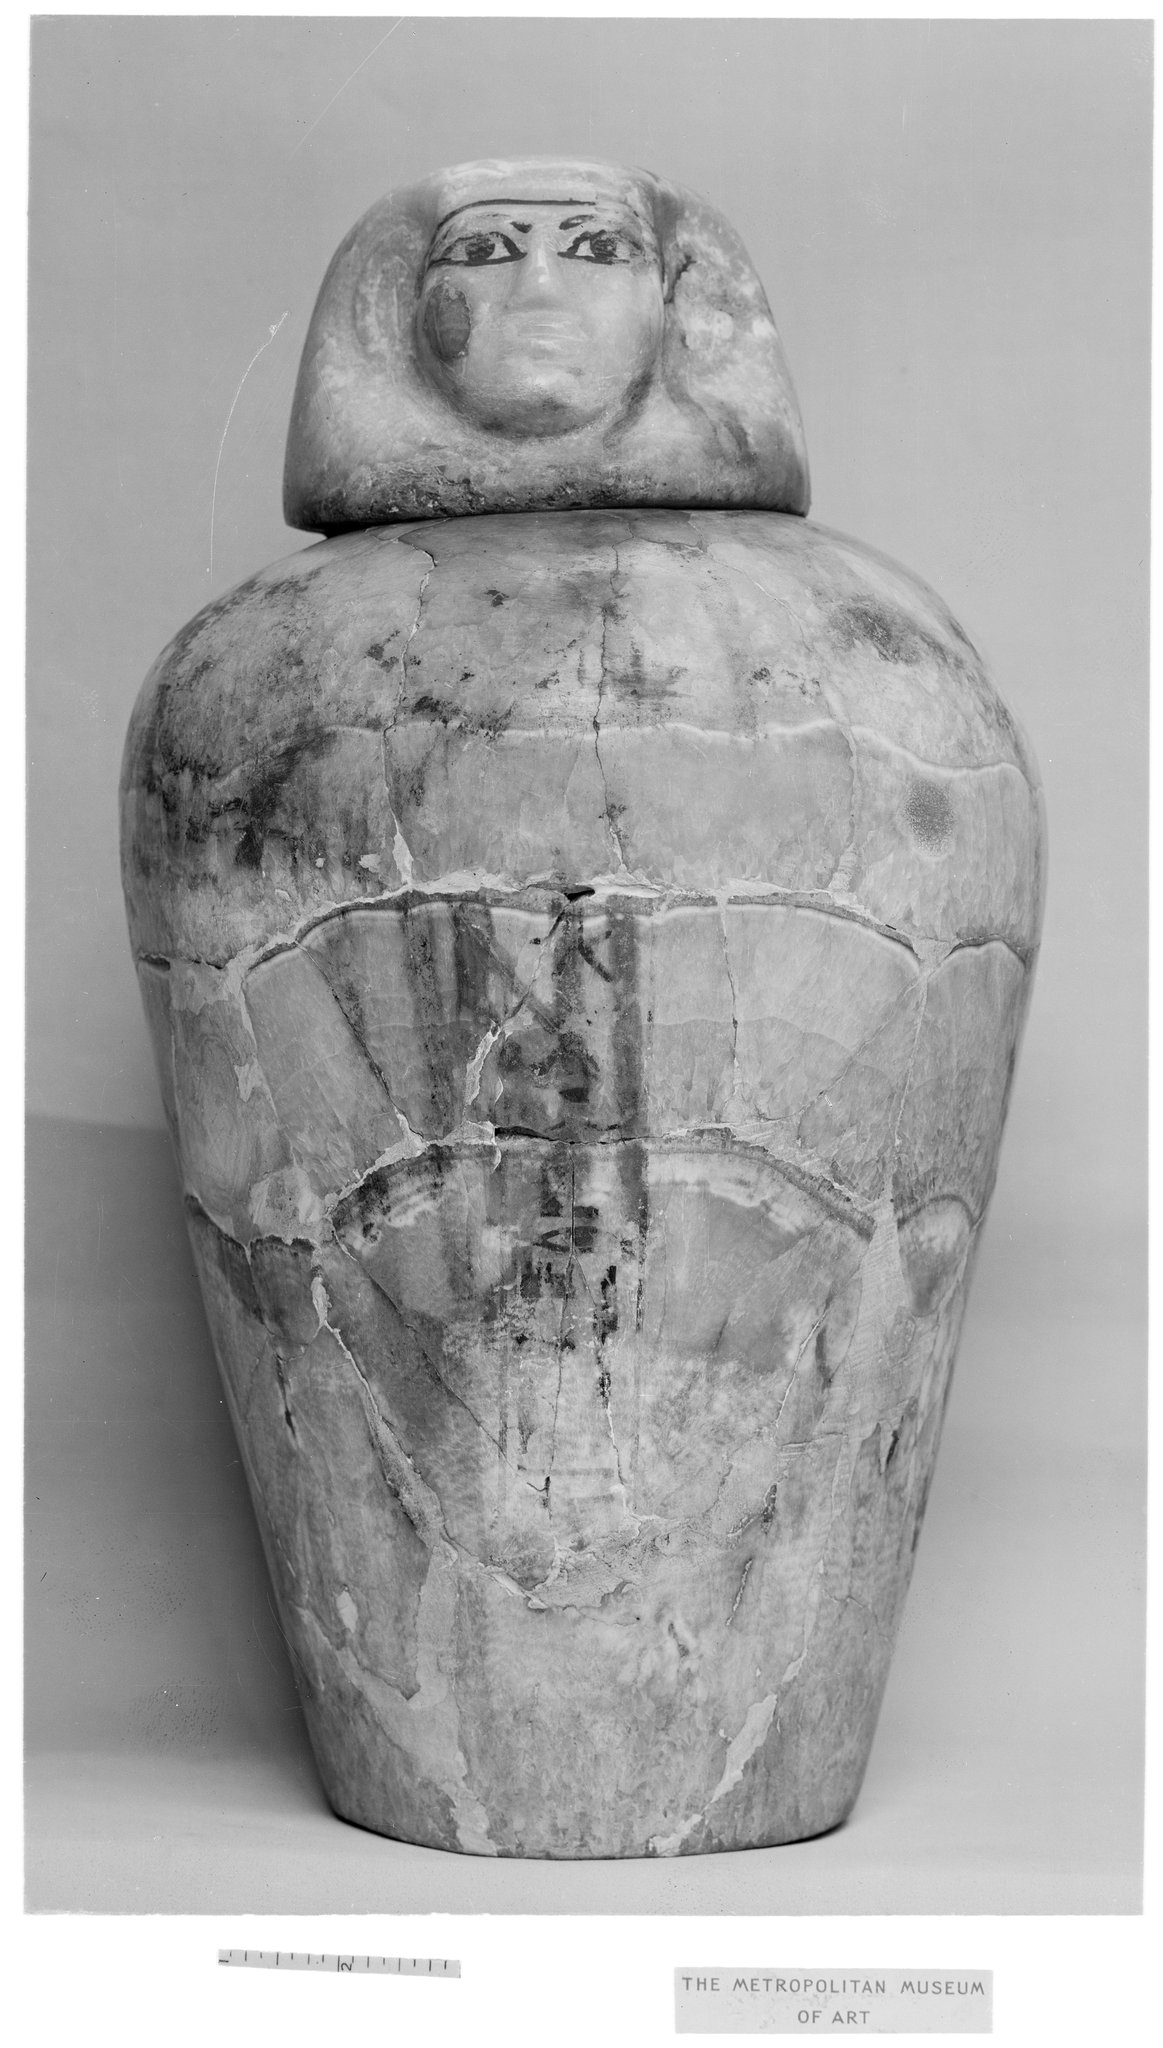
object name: canopic jar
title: Canopic jar of Ameny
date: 1950-1750 BCE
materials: stone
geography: egypt